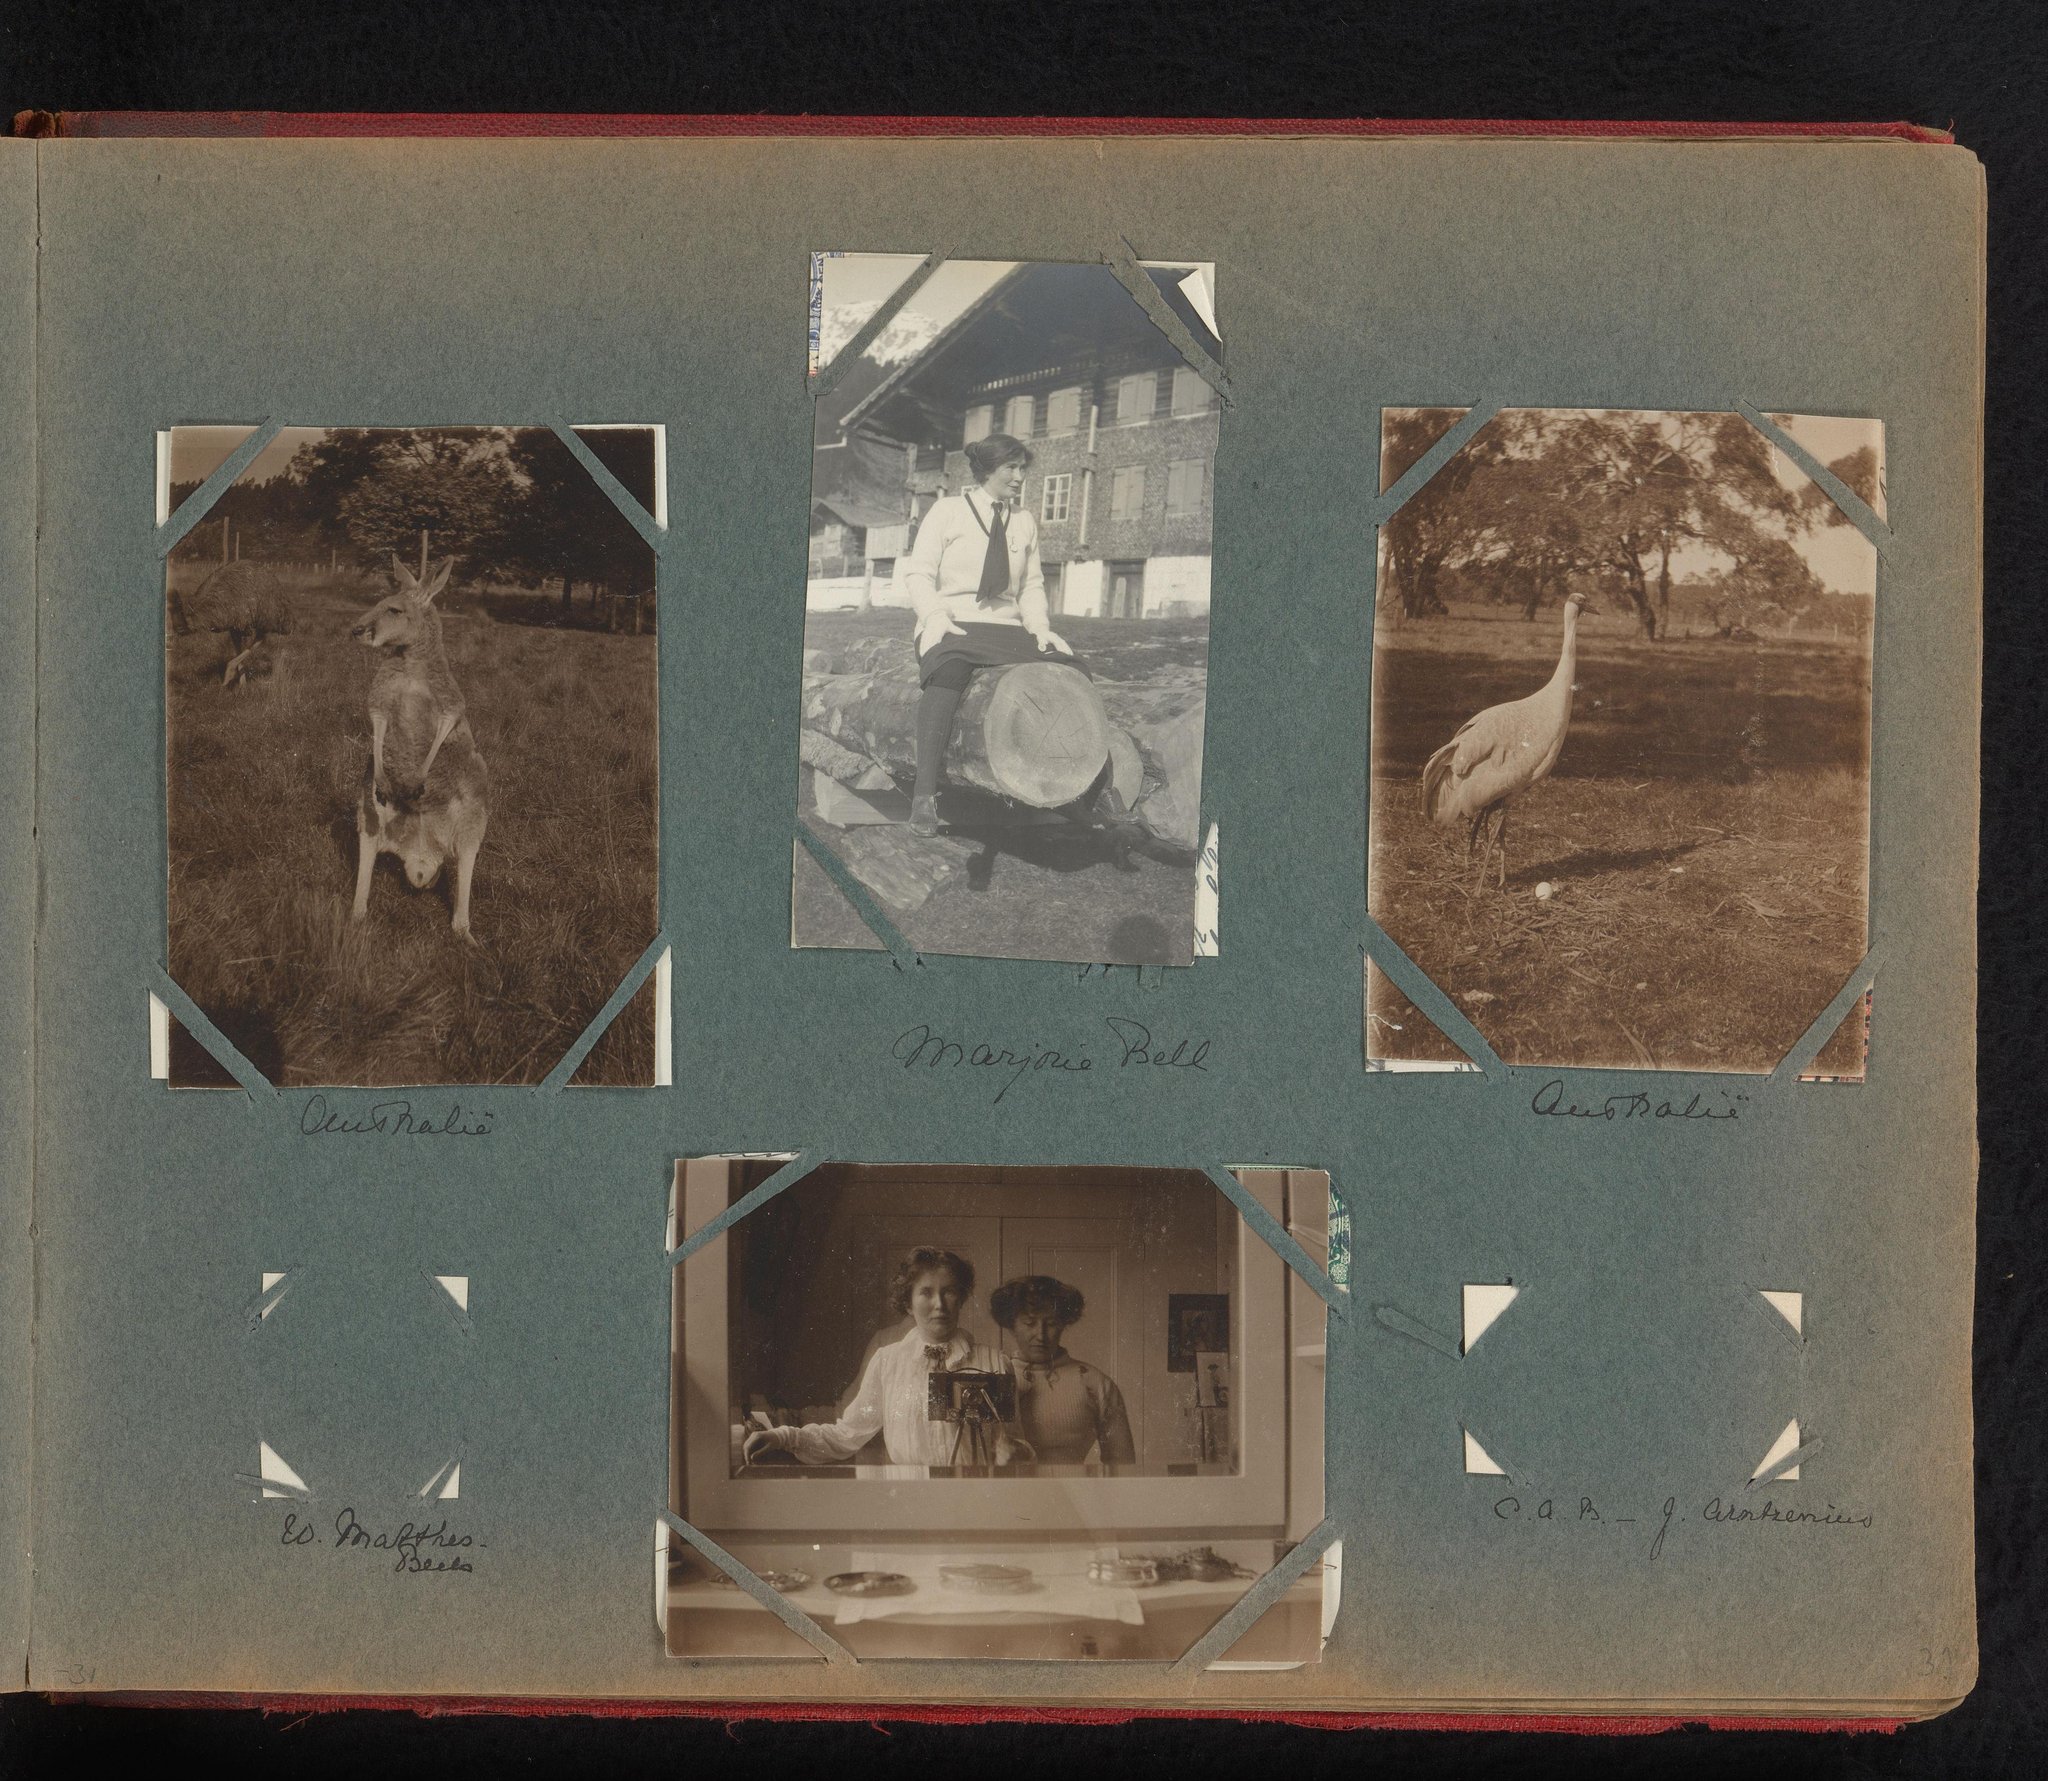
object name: photograph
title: Vier gezichten uit Australië, waaronder een zelfportret van Majorie Bell met een vriendin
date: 1912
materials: paper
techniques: gelatin silver print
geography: australia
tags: marjorie bell, other mammals (with name), birds, portrait, self-portrait of photographer, australia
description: Deze foto's zijn onderdeel van een album.